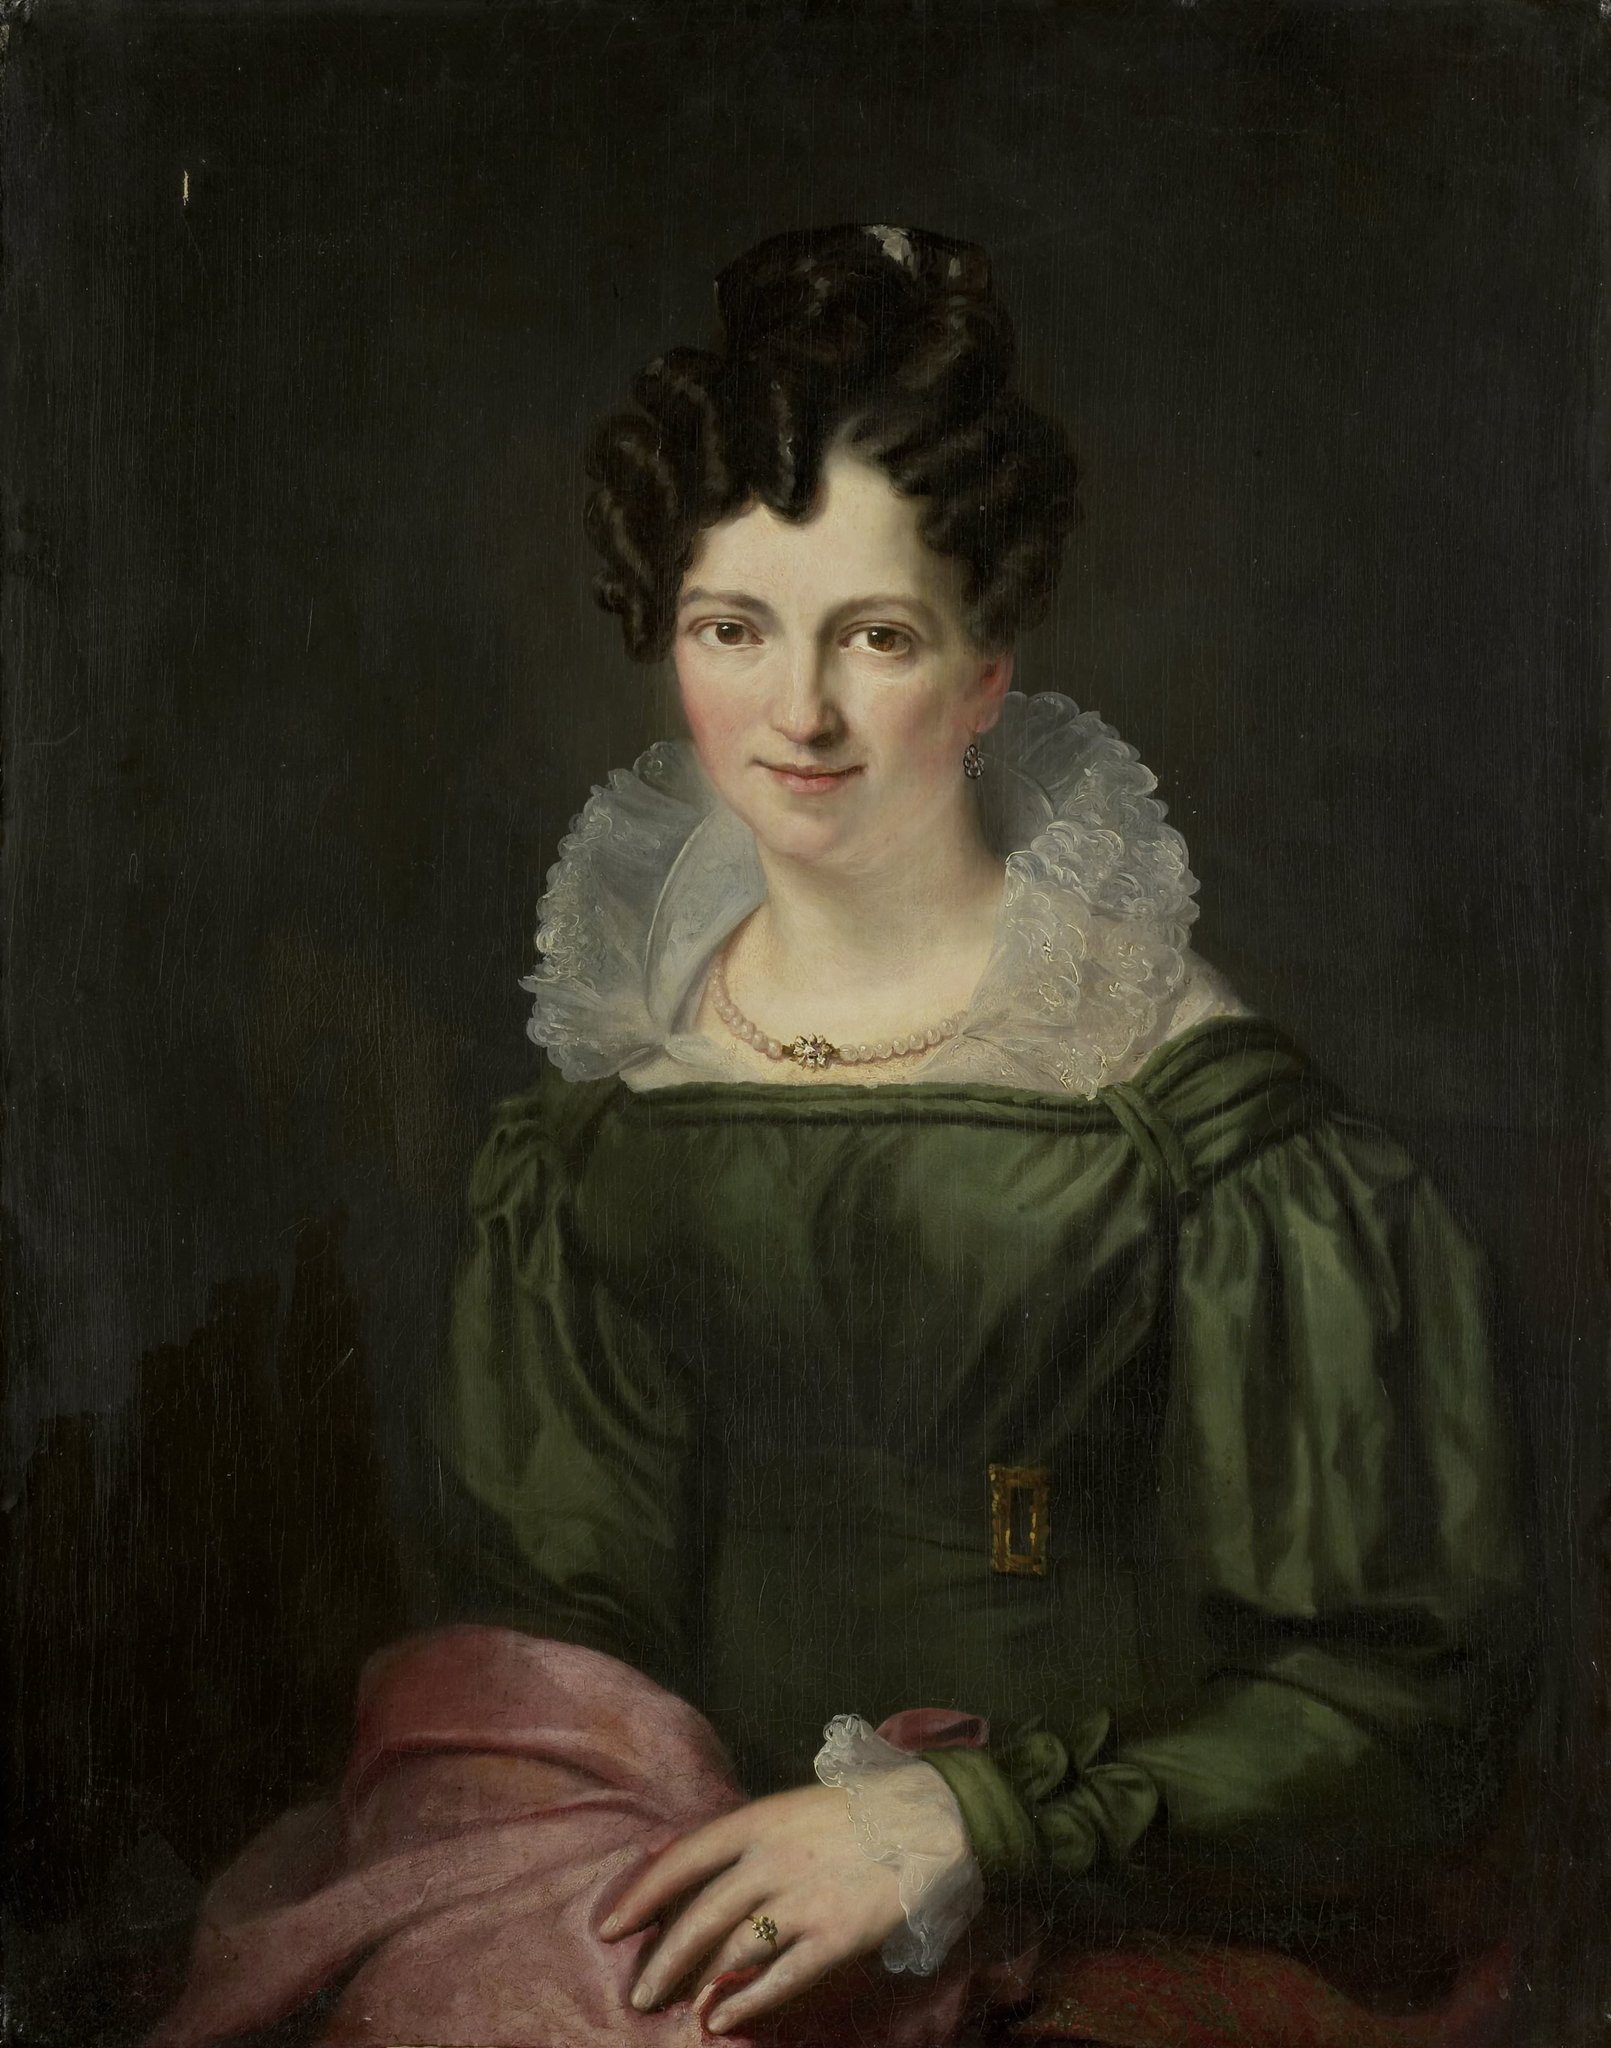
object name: painting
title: Portrait of Maria Christina Nijssen, Wife of Anthonie van der Hout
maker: christiaan julius lodewijk portman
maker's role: draughtsman, painter, print maker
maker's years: 1799-1868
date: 1826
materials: canvas, oil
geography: netherlands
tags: maria christina nijsen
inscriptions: signature and date: ‘C.J.L. Portman 1826’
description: Portret van Maria Christina Nijssen (1788-1870), echtgenote van Anthonie van der Hout. Ten halven lijve, zittend in een fauteuil. Pendant van SK-A-4167.